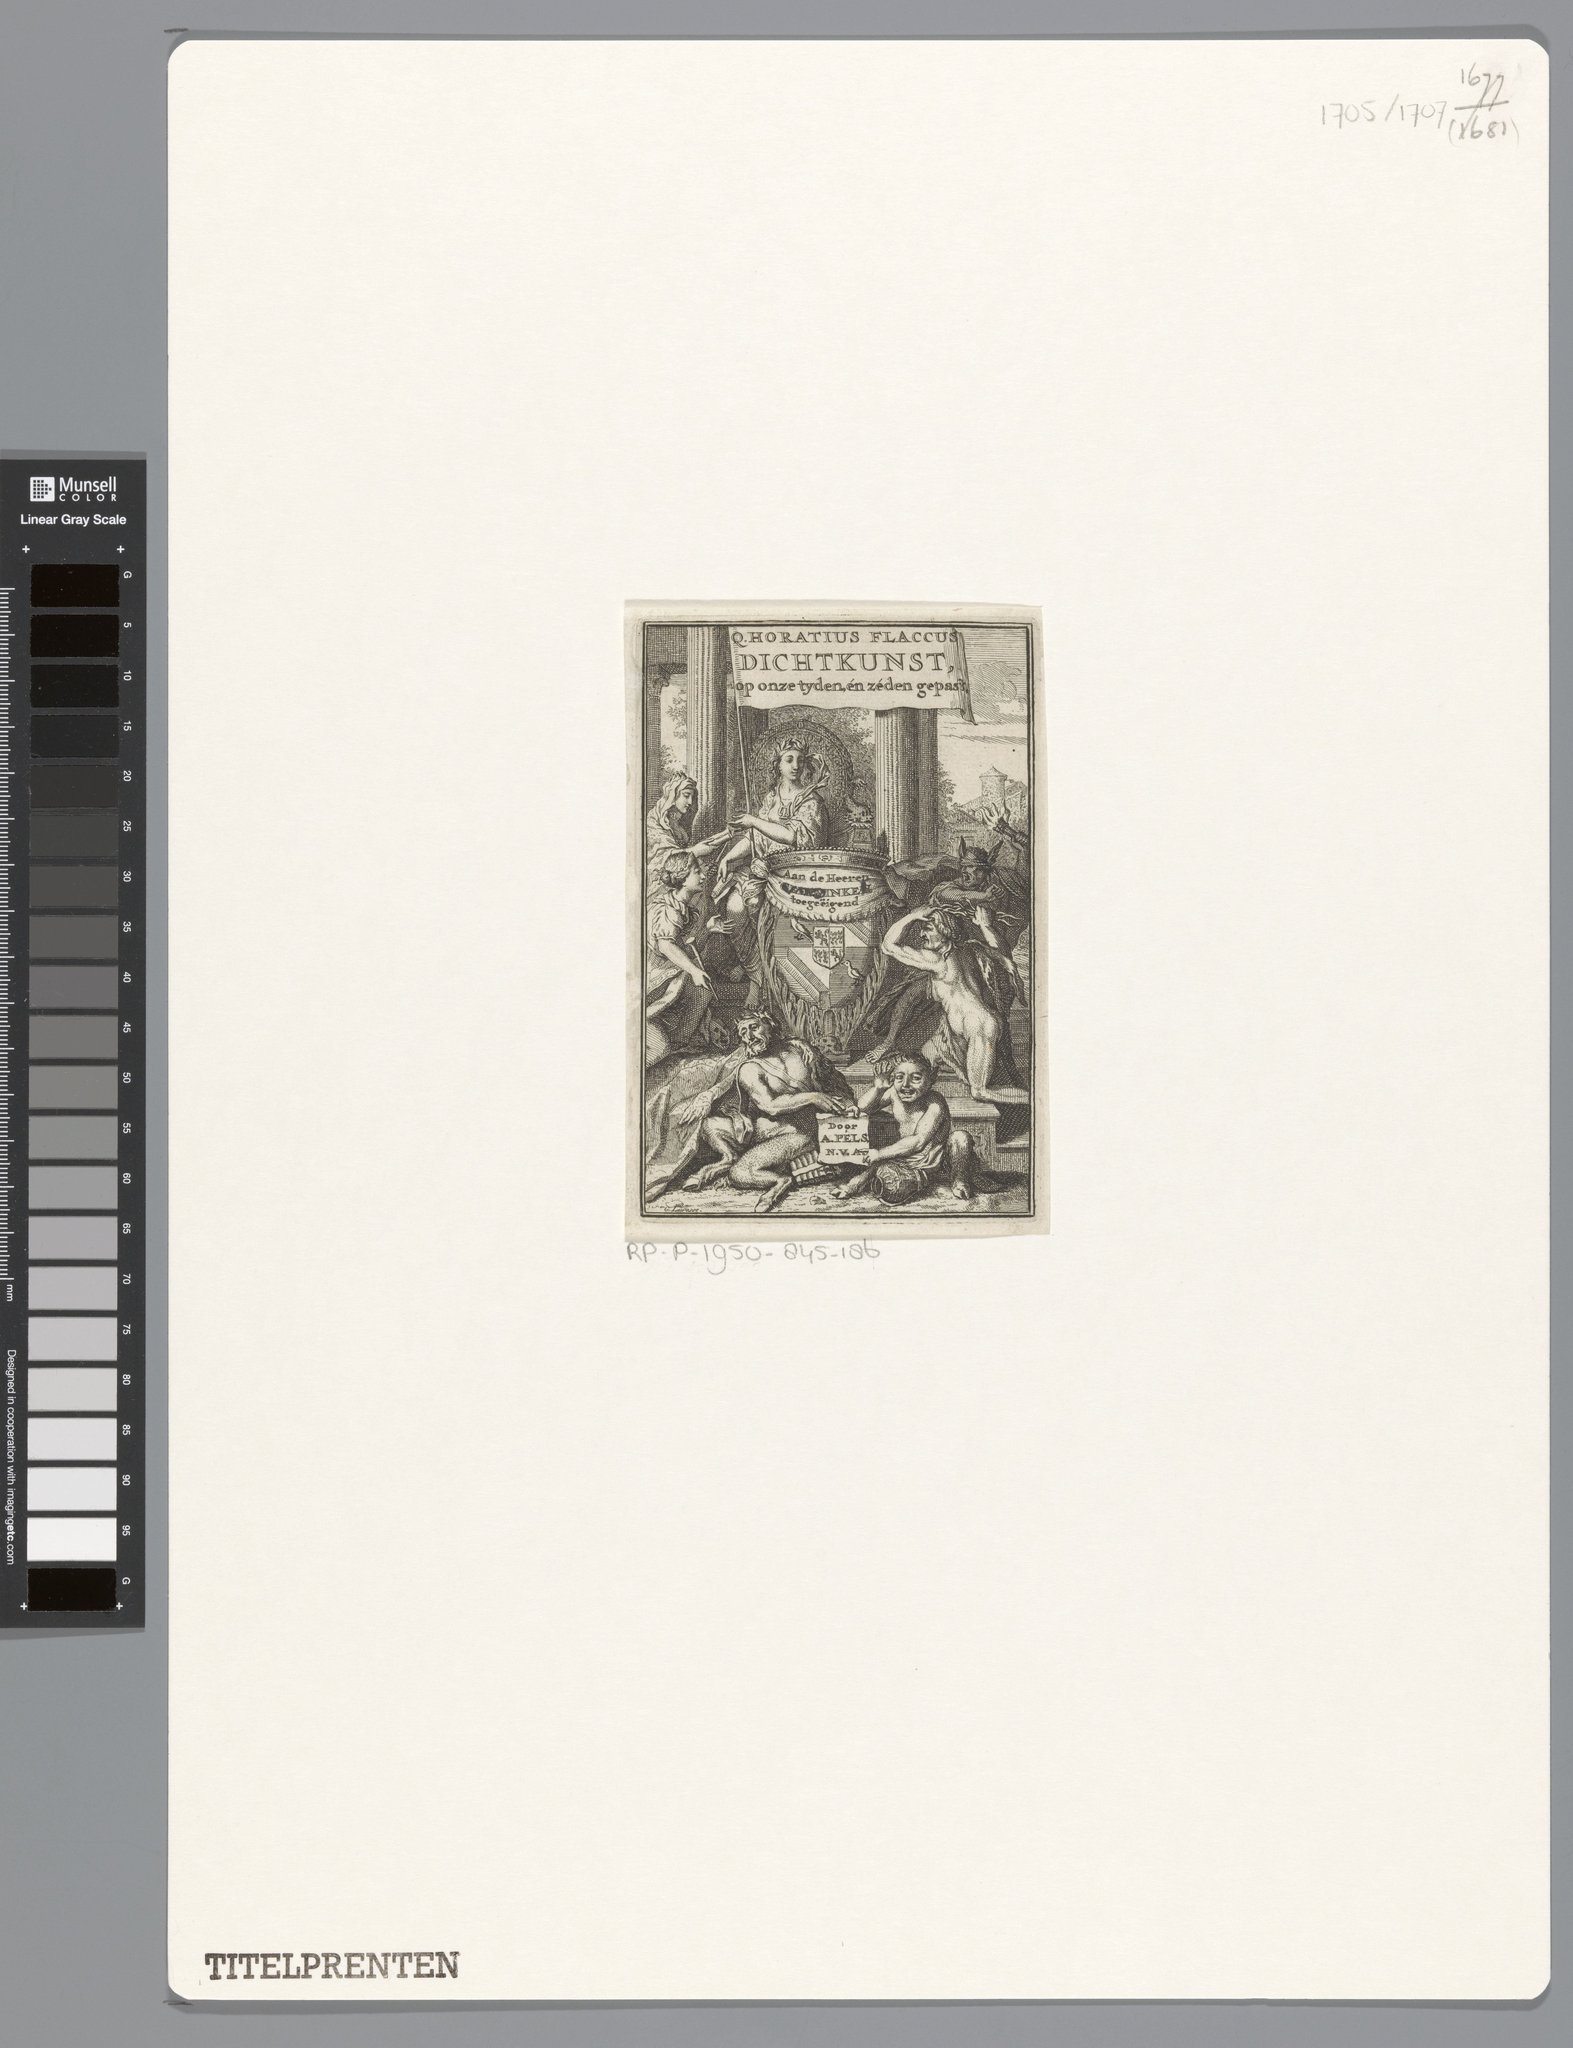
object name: print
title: Allegorische voorstelling met Dichtkunst, Onwetendheid, Nijd en muzes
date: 1705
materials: paper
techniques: etching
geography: amsterdam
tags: symbolic representations, allegories and emblems ~ poetry; 'poesia' (ripa), single muses, invidia (envy) as roman personification, stupidity, poverty of intellect; 'stupidità overo stolidità' (ripa)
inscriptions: collector's mark: Lugt 2228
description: Titelpagina voor: Pels, Andries en Horatius. Dichtkunst, op onze tyden, én zéden gepast. Amsterdam: Lescailje, erven Jacob, 1705. Prent afkomstig uit een plakalbum met titelprenten, ornamenten etc. op blauw papier in 1983 uit elkaar gehaald. Volgens een notitie op verso zat de prent op p. 186 van dit album.